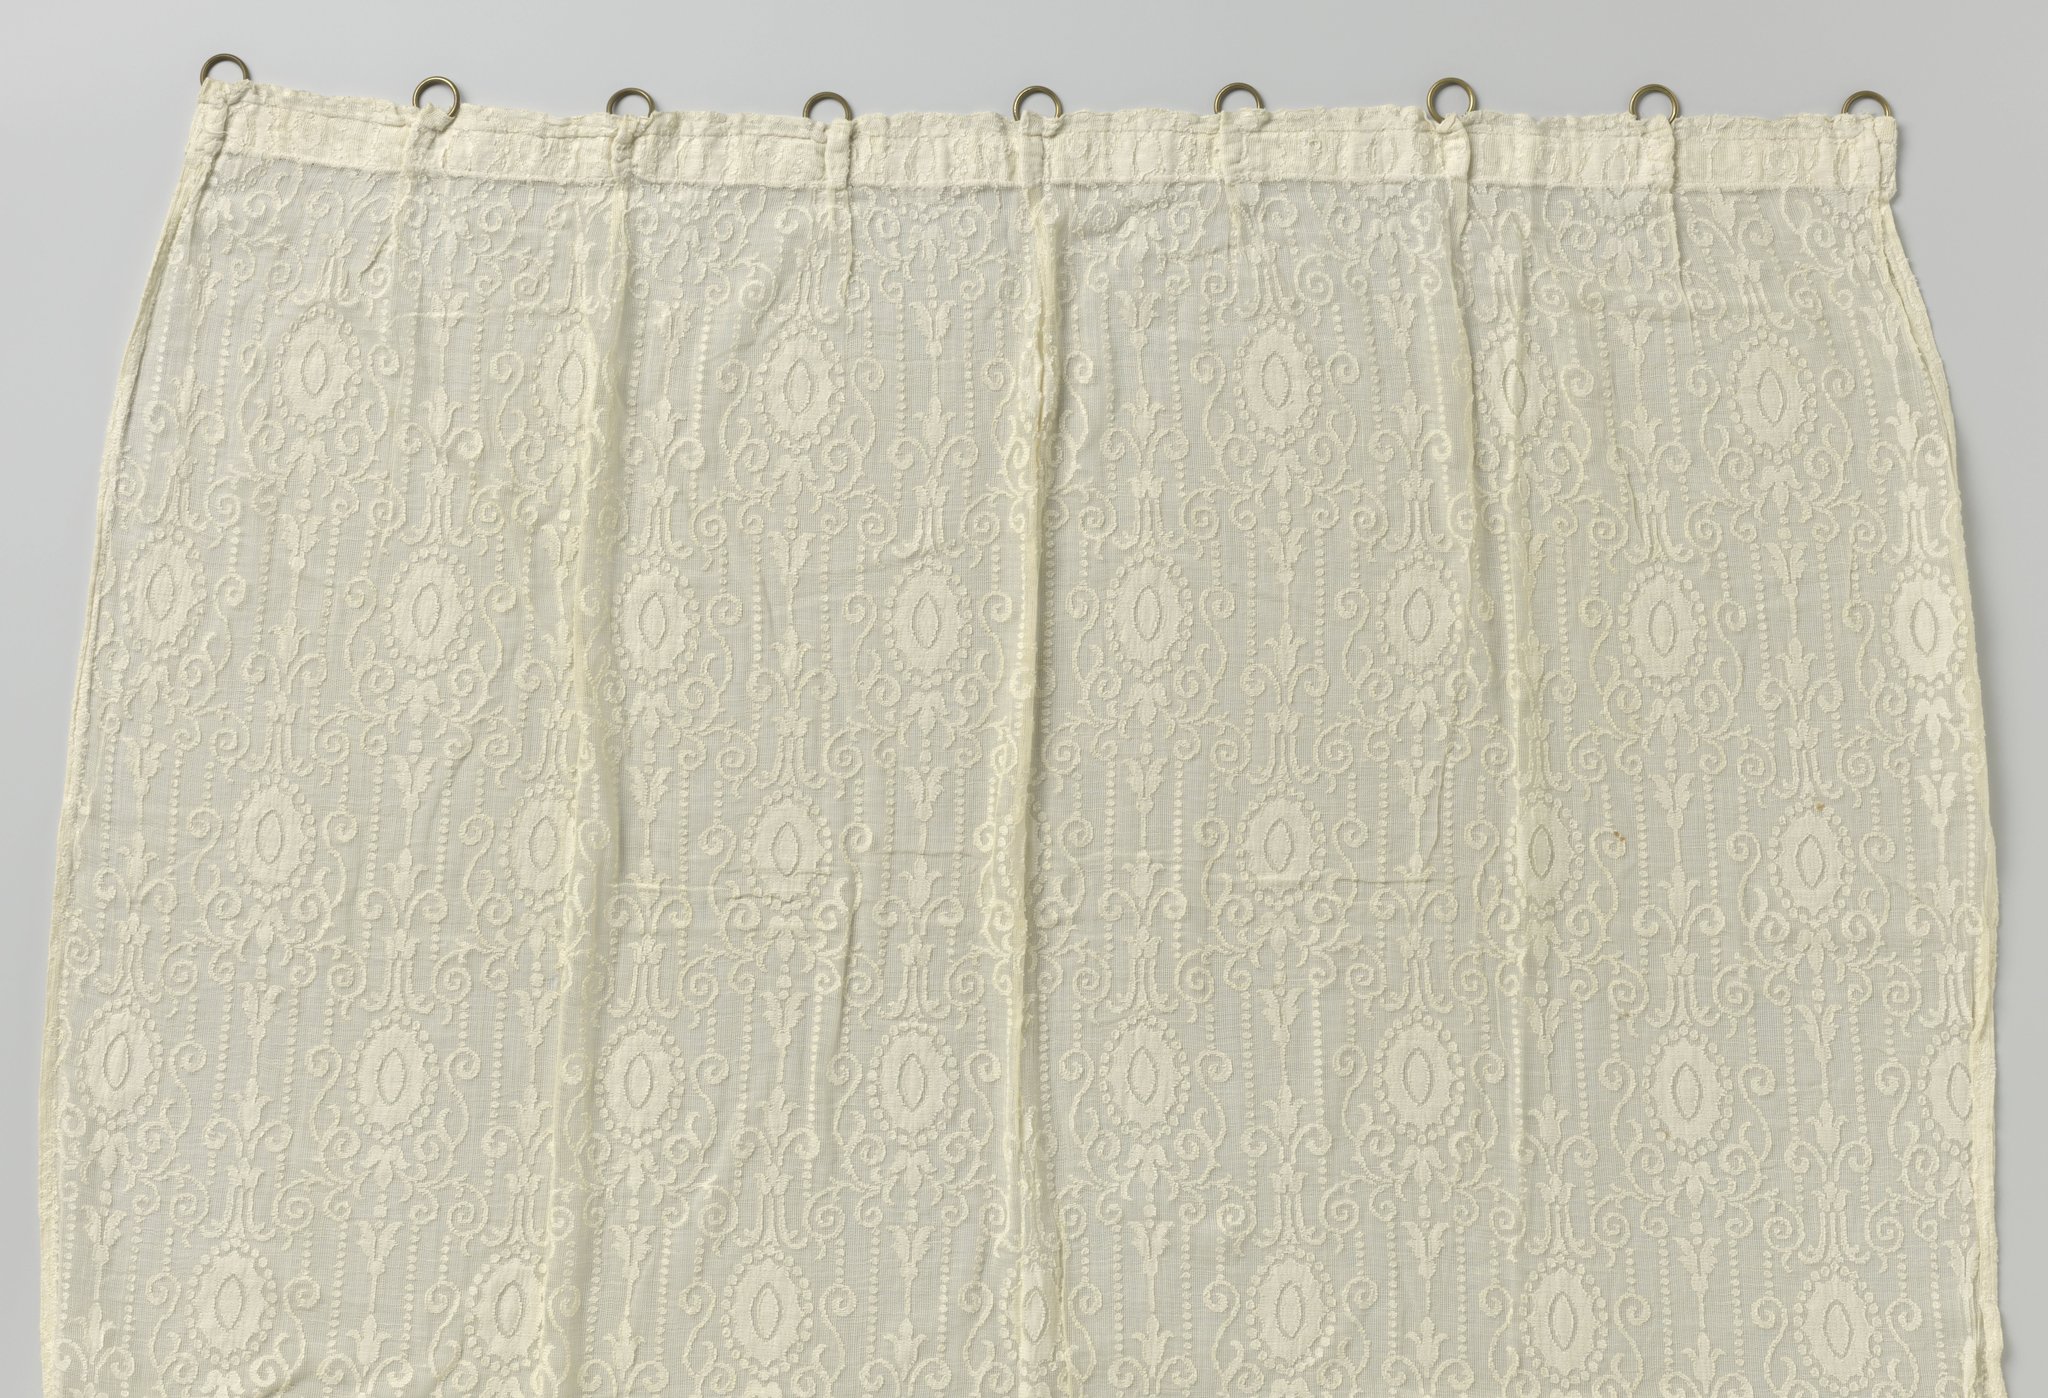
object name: curtain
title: Vitrage in neo Lodewijk-XVI stijl, met koperen ringen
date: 1895-1905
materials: copper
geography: netherlands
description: Vitrage in neo Lodewijk-XVIe stijl, met koperen ringen.